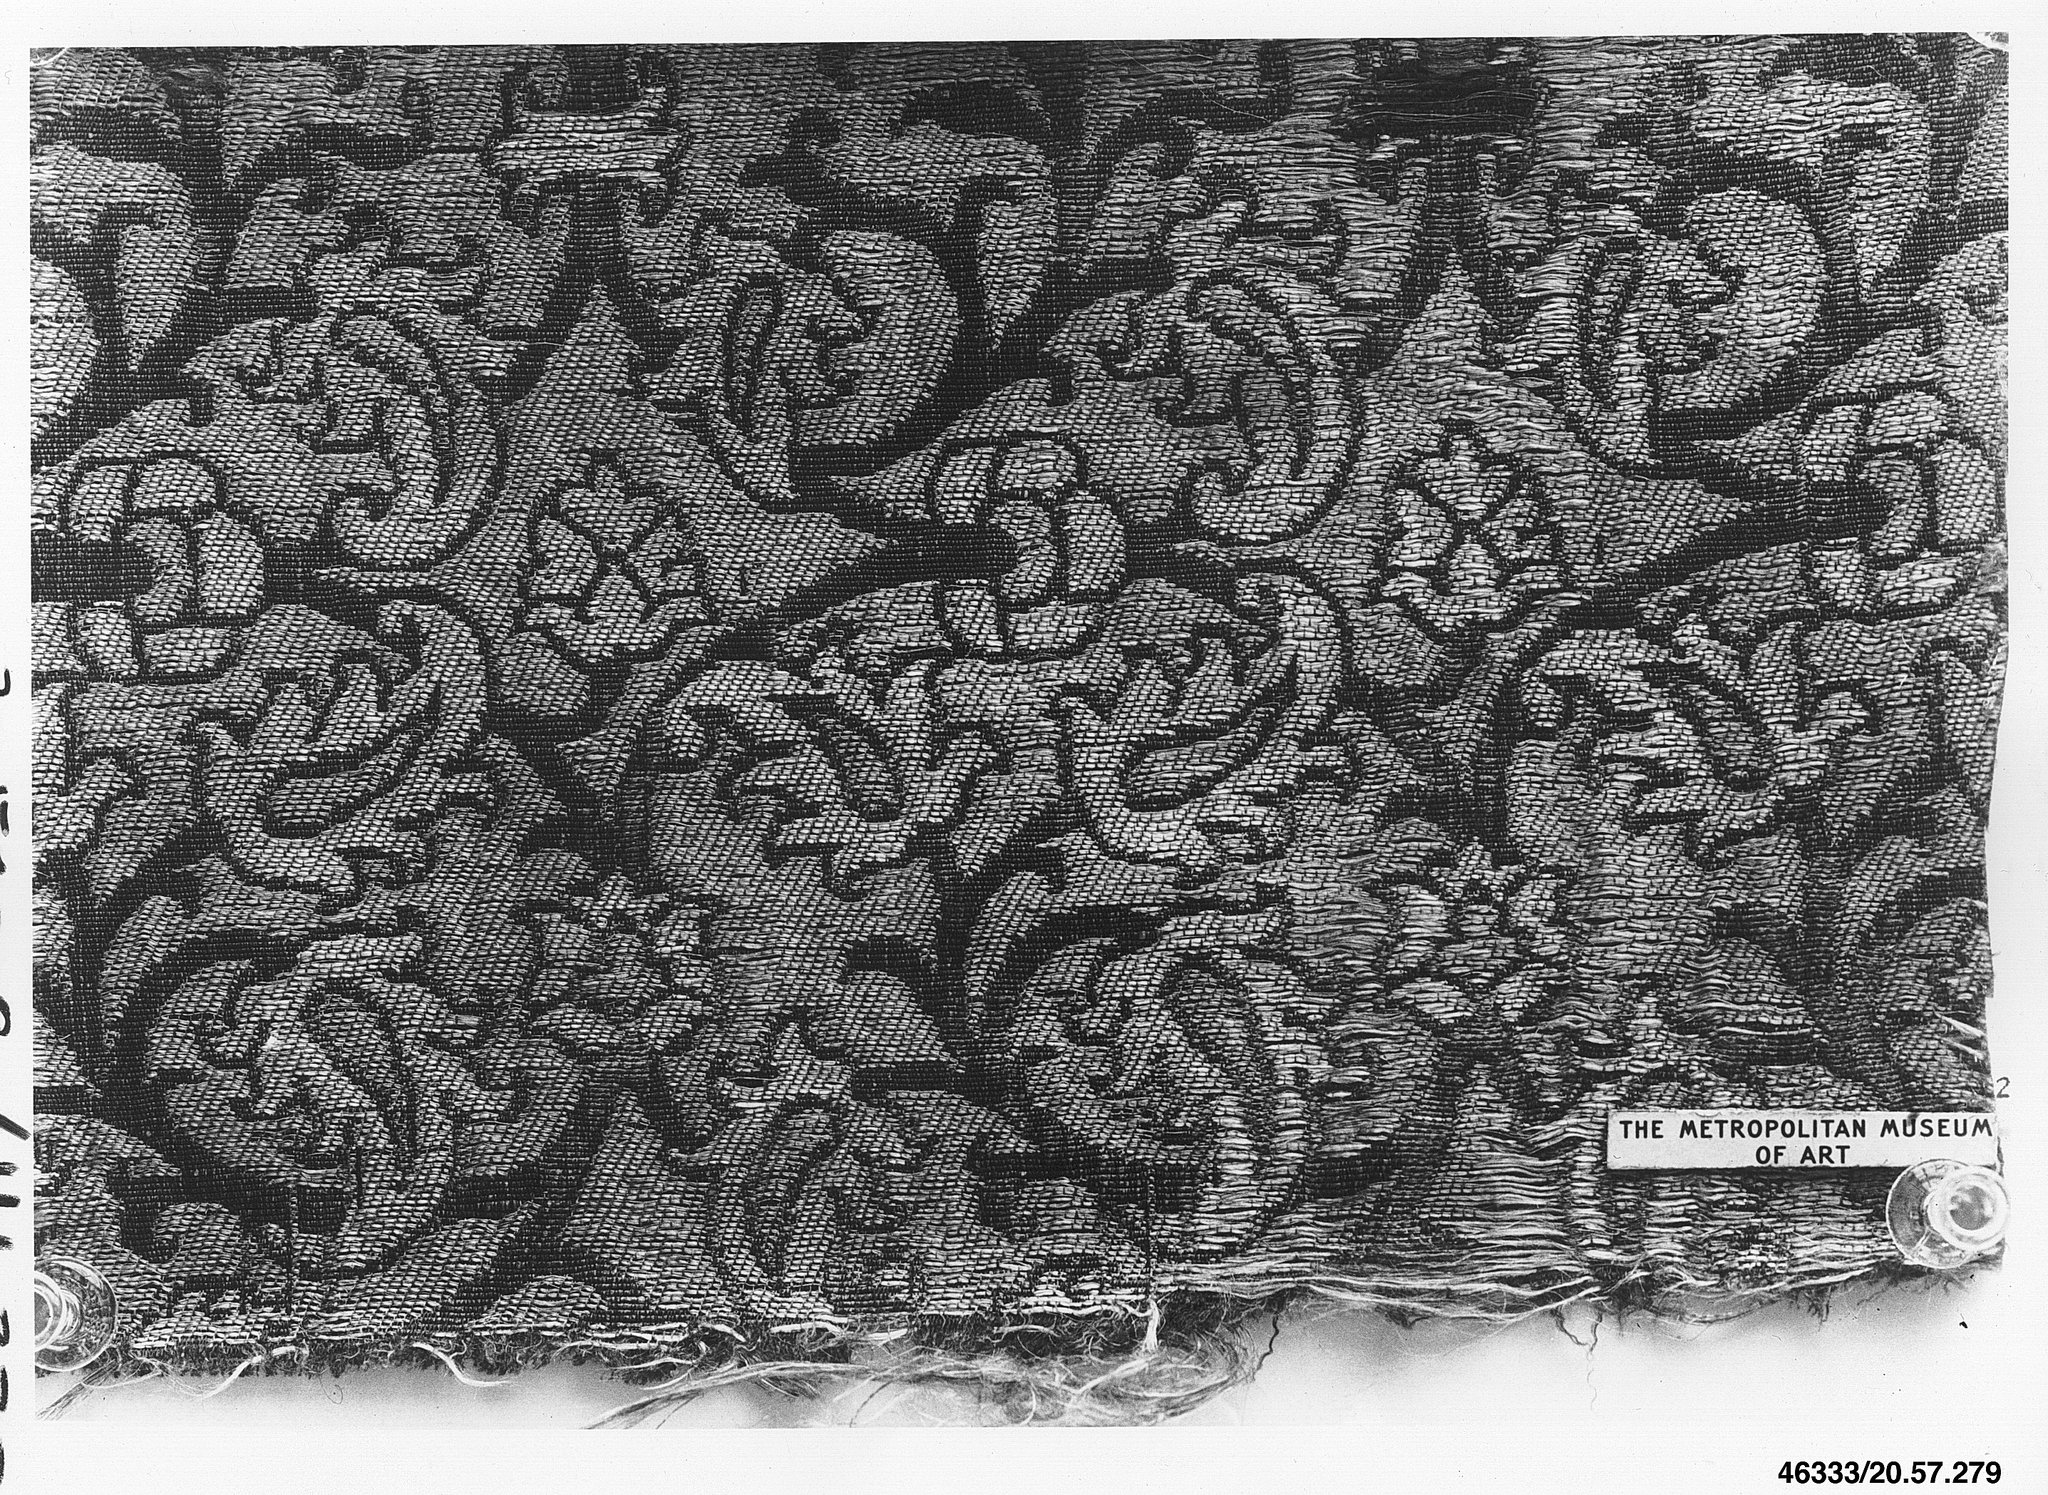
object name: piece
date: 1567-1600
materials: silk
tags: flowers,leaves